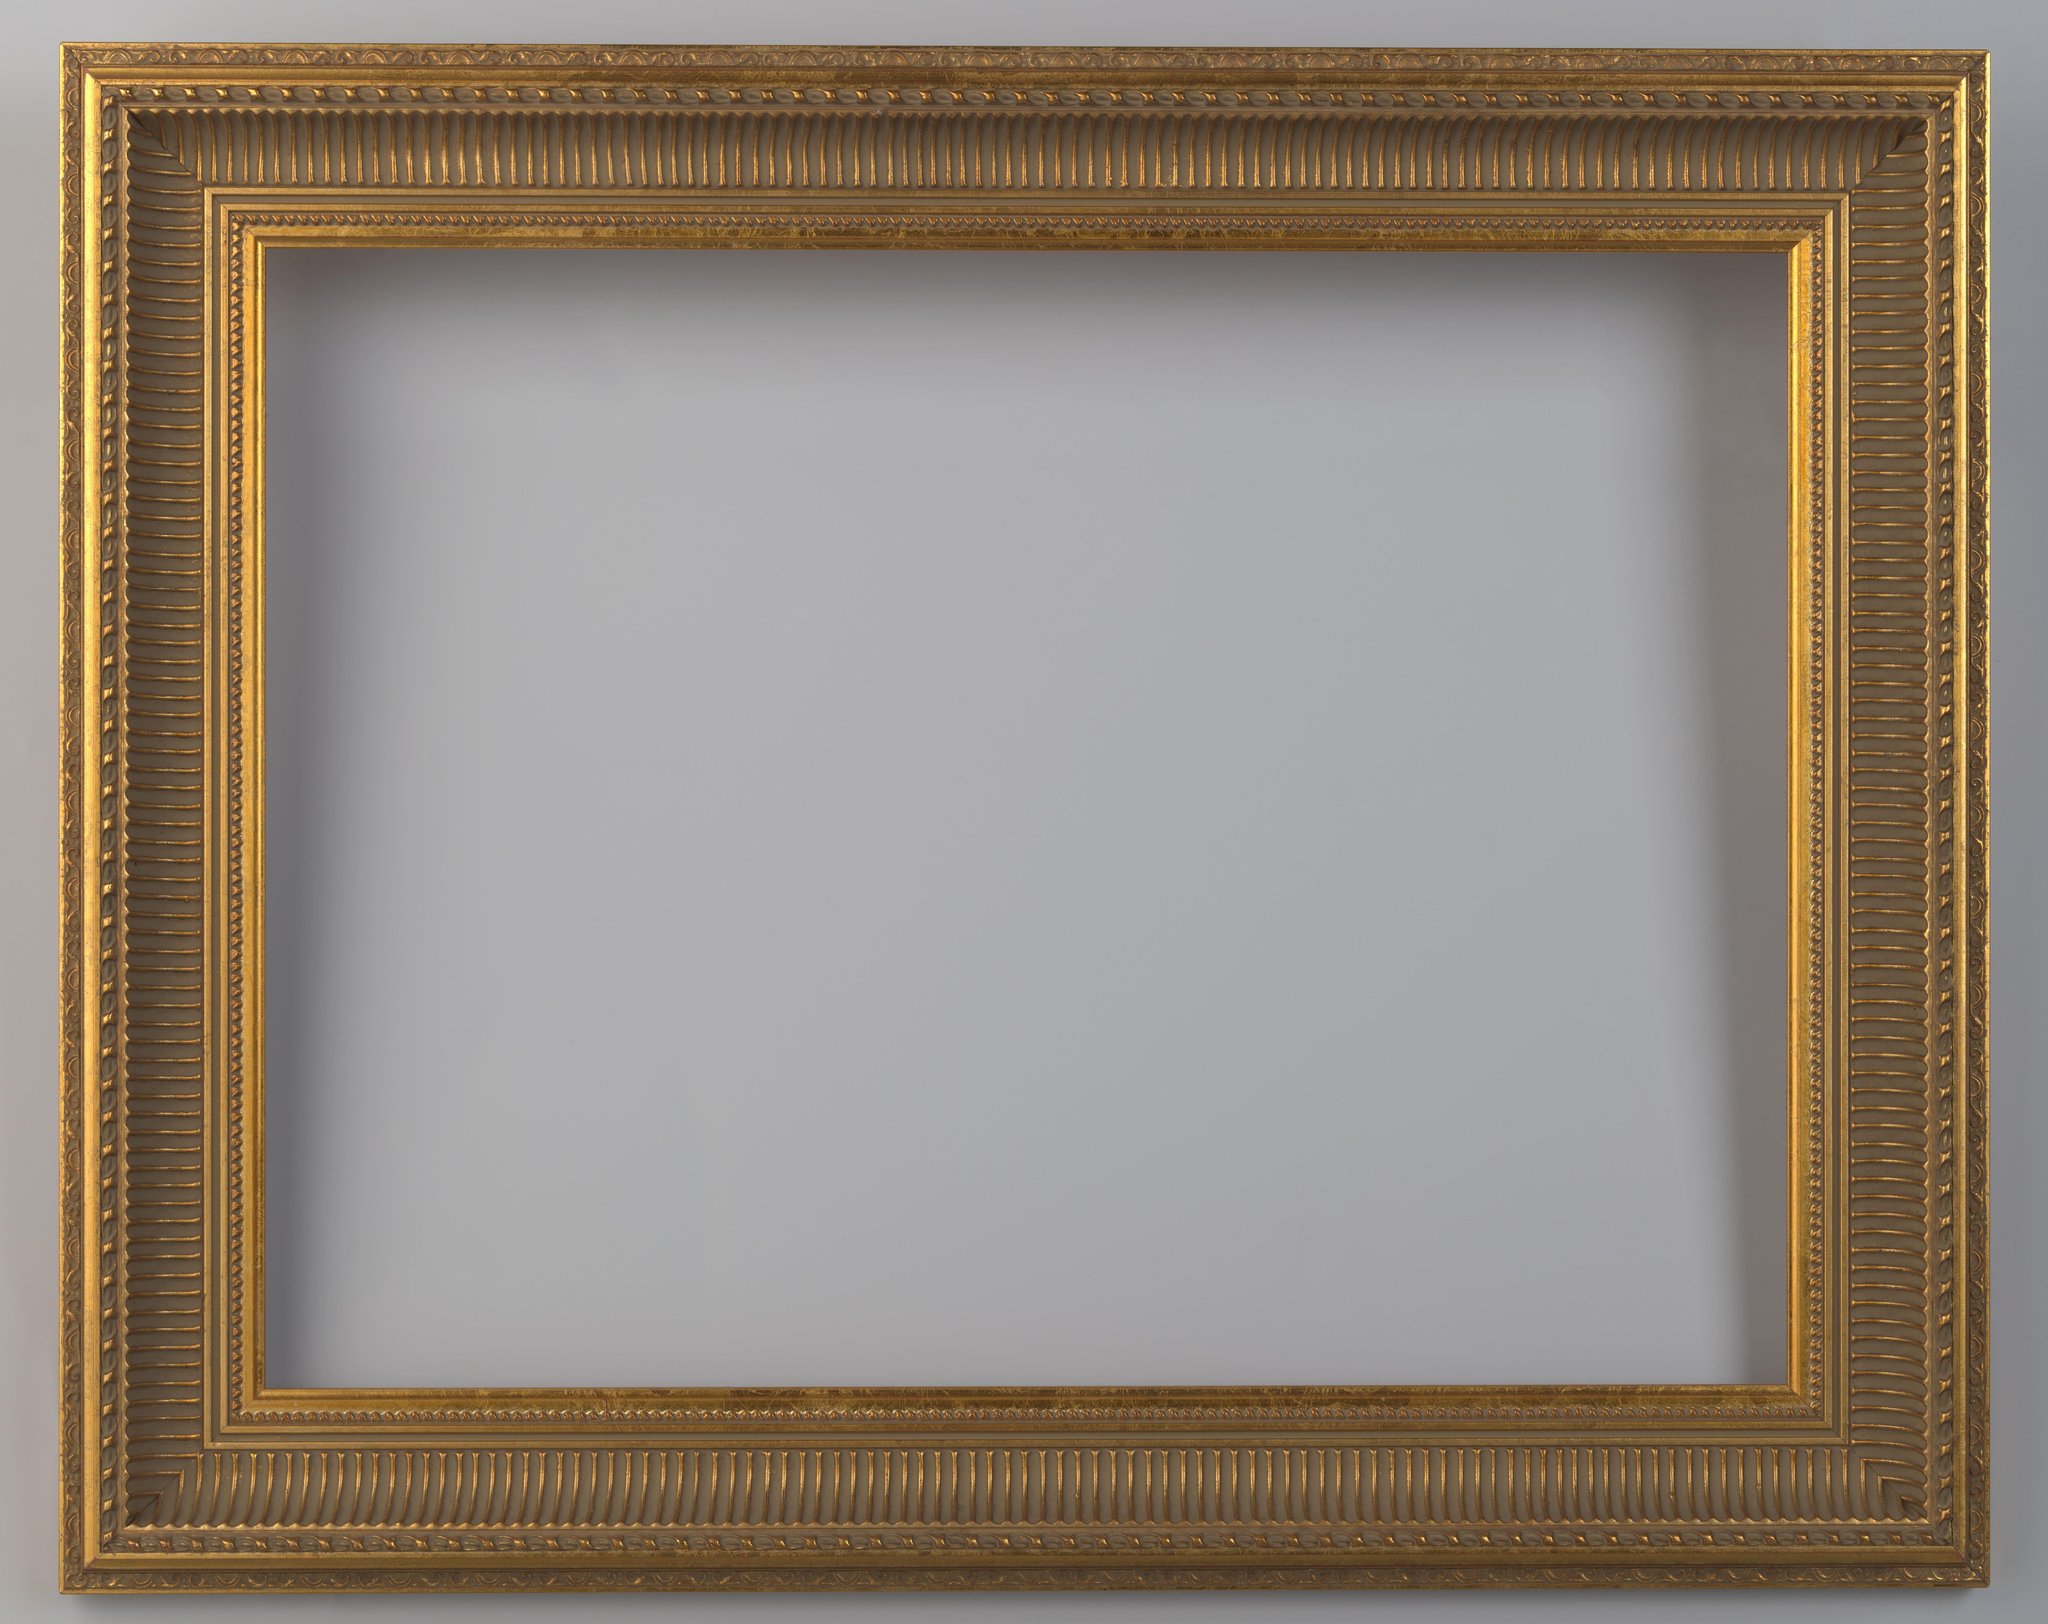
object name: frame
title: Lijst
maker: Anonymous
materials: wood